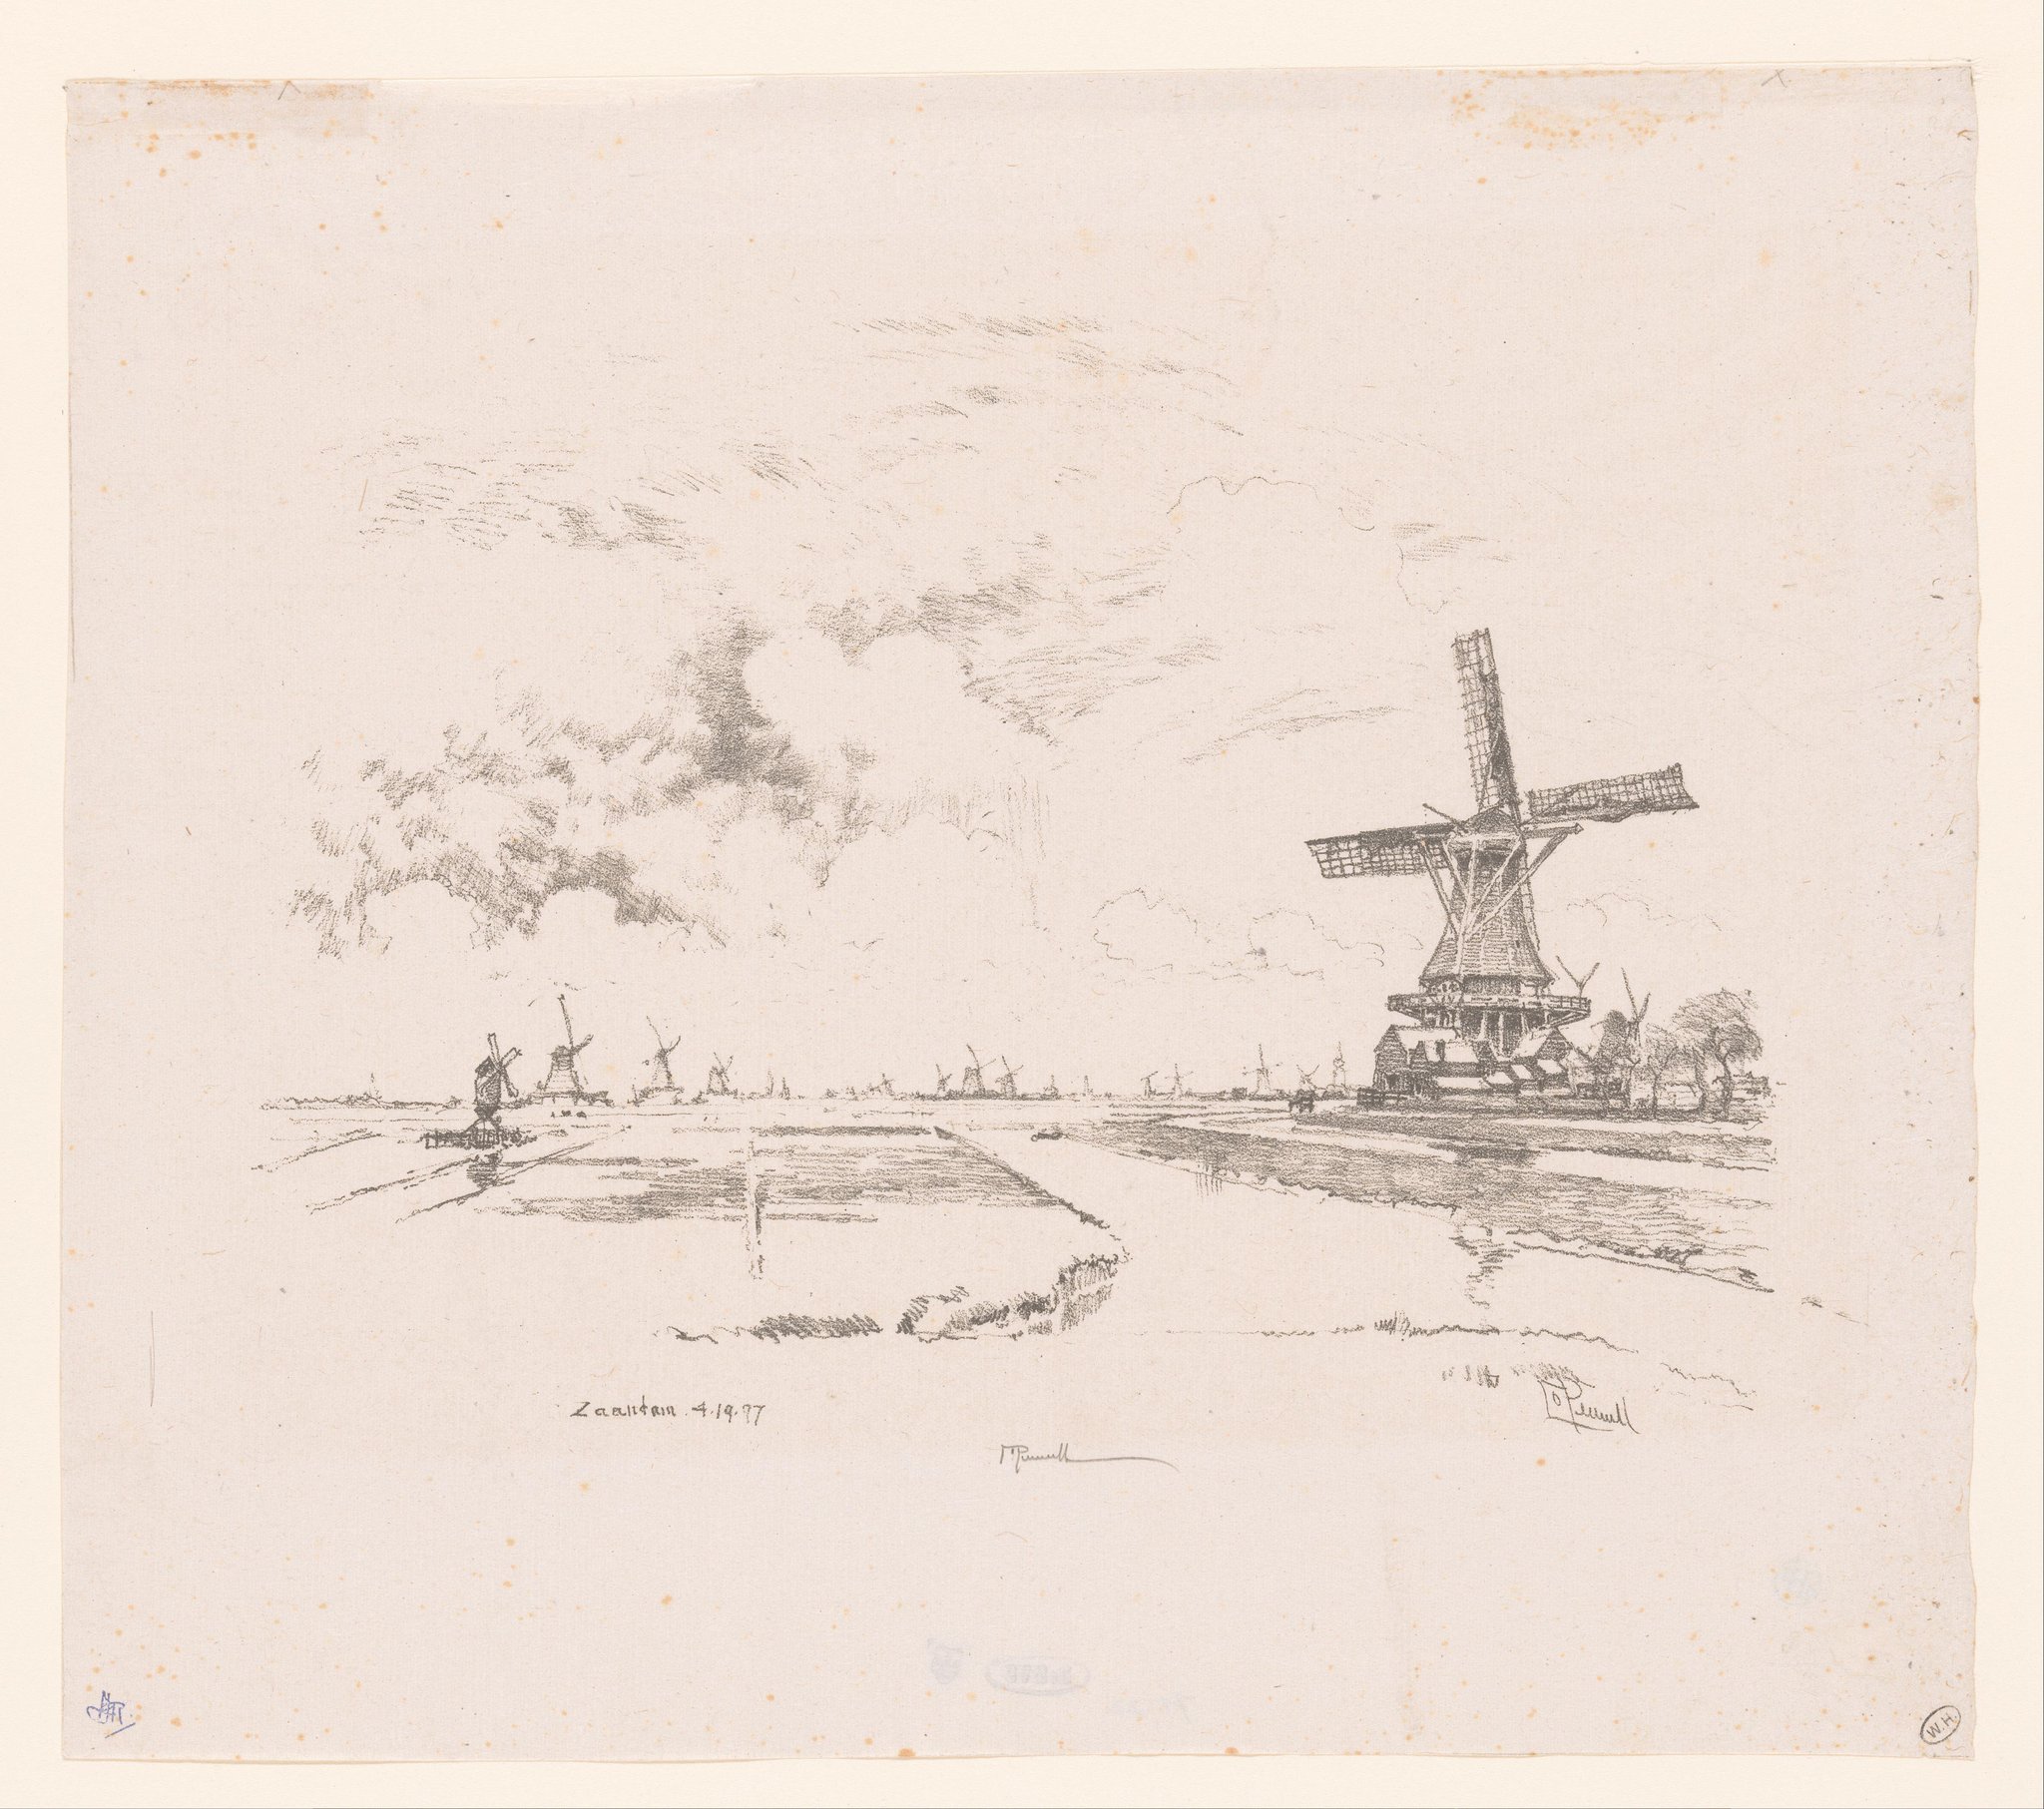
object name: print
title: Gezicht op Zaandam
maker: joseph pennell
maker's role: print maker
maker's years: 1857-1926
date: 1897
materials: paper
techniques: lithograph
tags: landscapes, windmill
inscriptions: collector's mark: Lugt 733, collector's mark: Lugt 2228, inscription: ‘Zaandam’, date: ‘4.19.97’, collector's mark: Lugt 2760, signature: ‘JoPennell’, signature: ‘JoPennell’, collector's mark: Lugt 2625